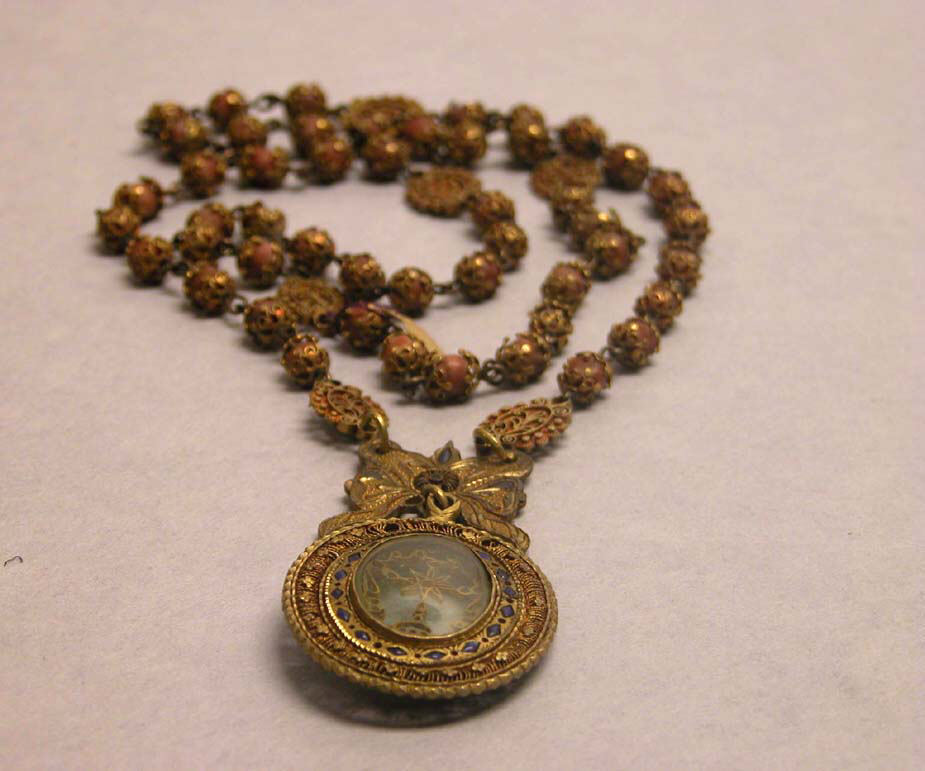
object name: necklace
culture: filipino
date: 1601-1900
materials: coral, enamel, gold